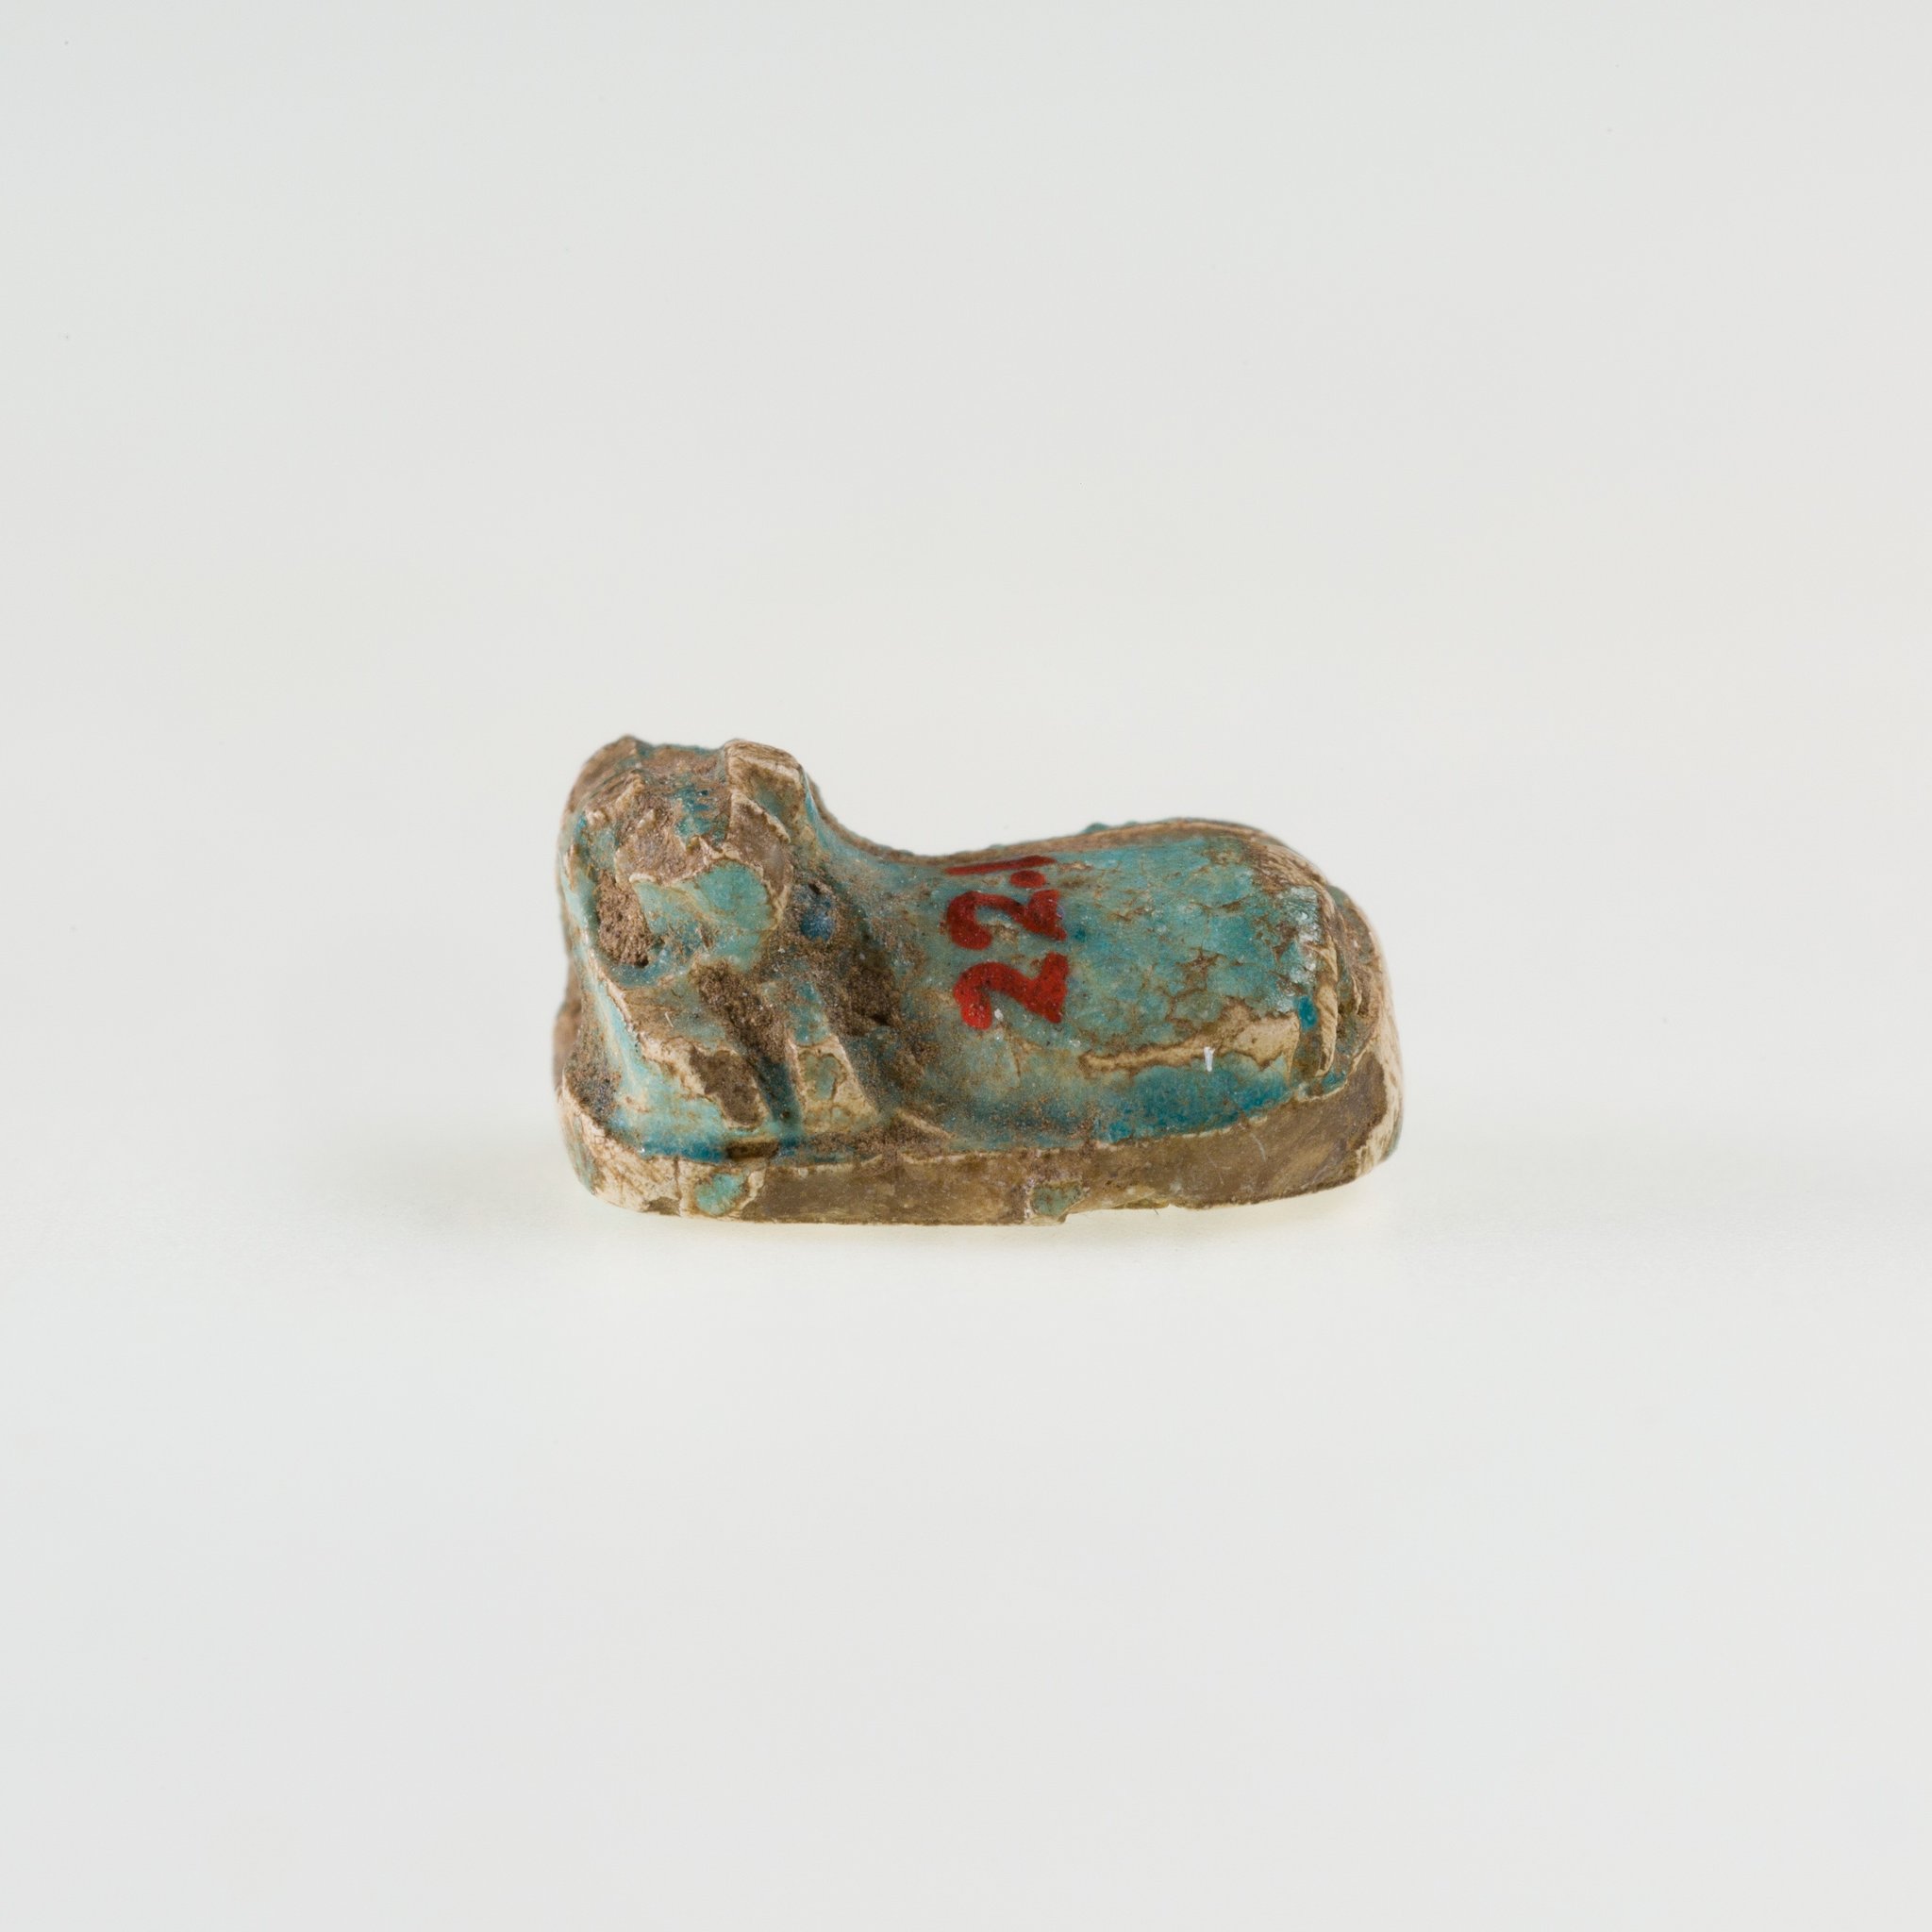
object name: recumbent lion or hippo, animal, rdi ra formula, may re give, hieroglyph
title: Animal-shaped Amulet Inscribed with a Blessing Related to Re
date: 1850-1640 BCE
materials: stone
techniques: glazing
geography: egypt